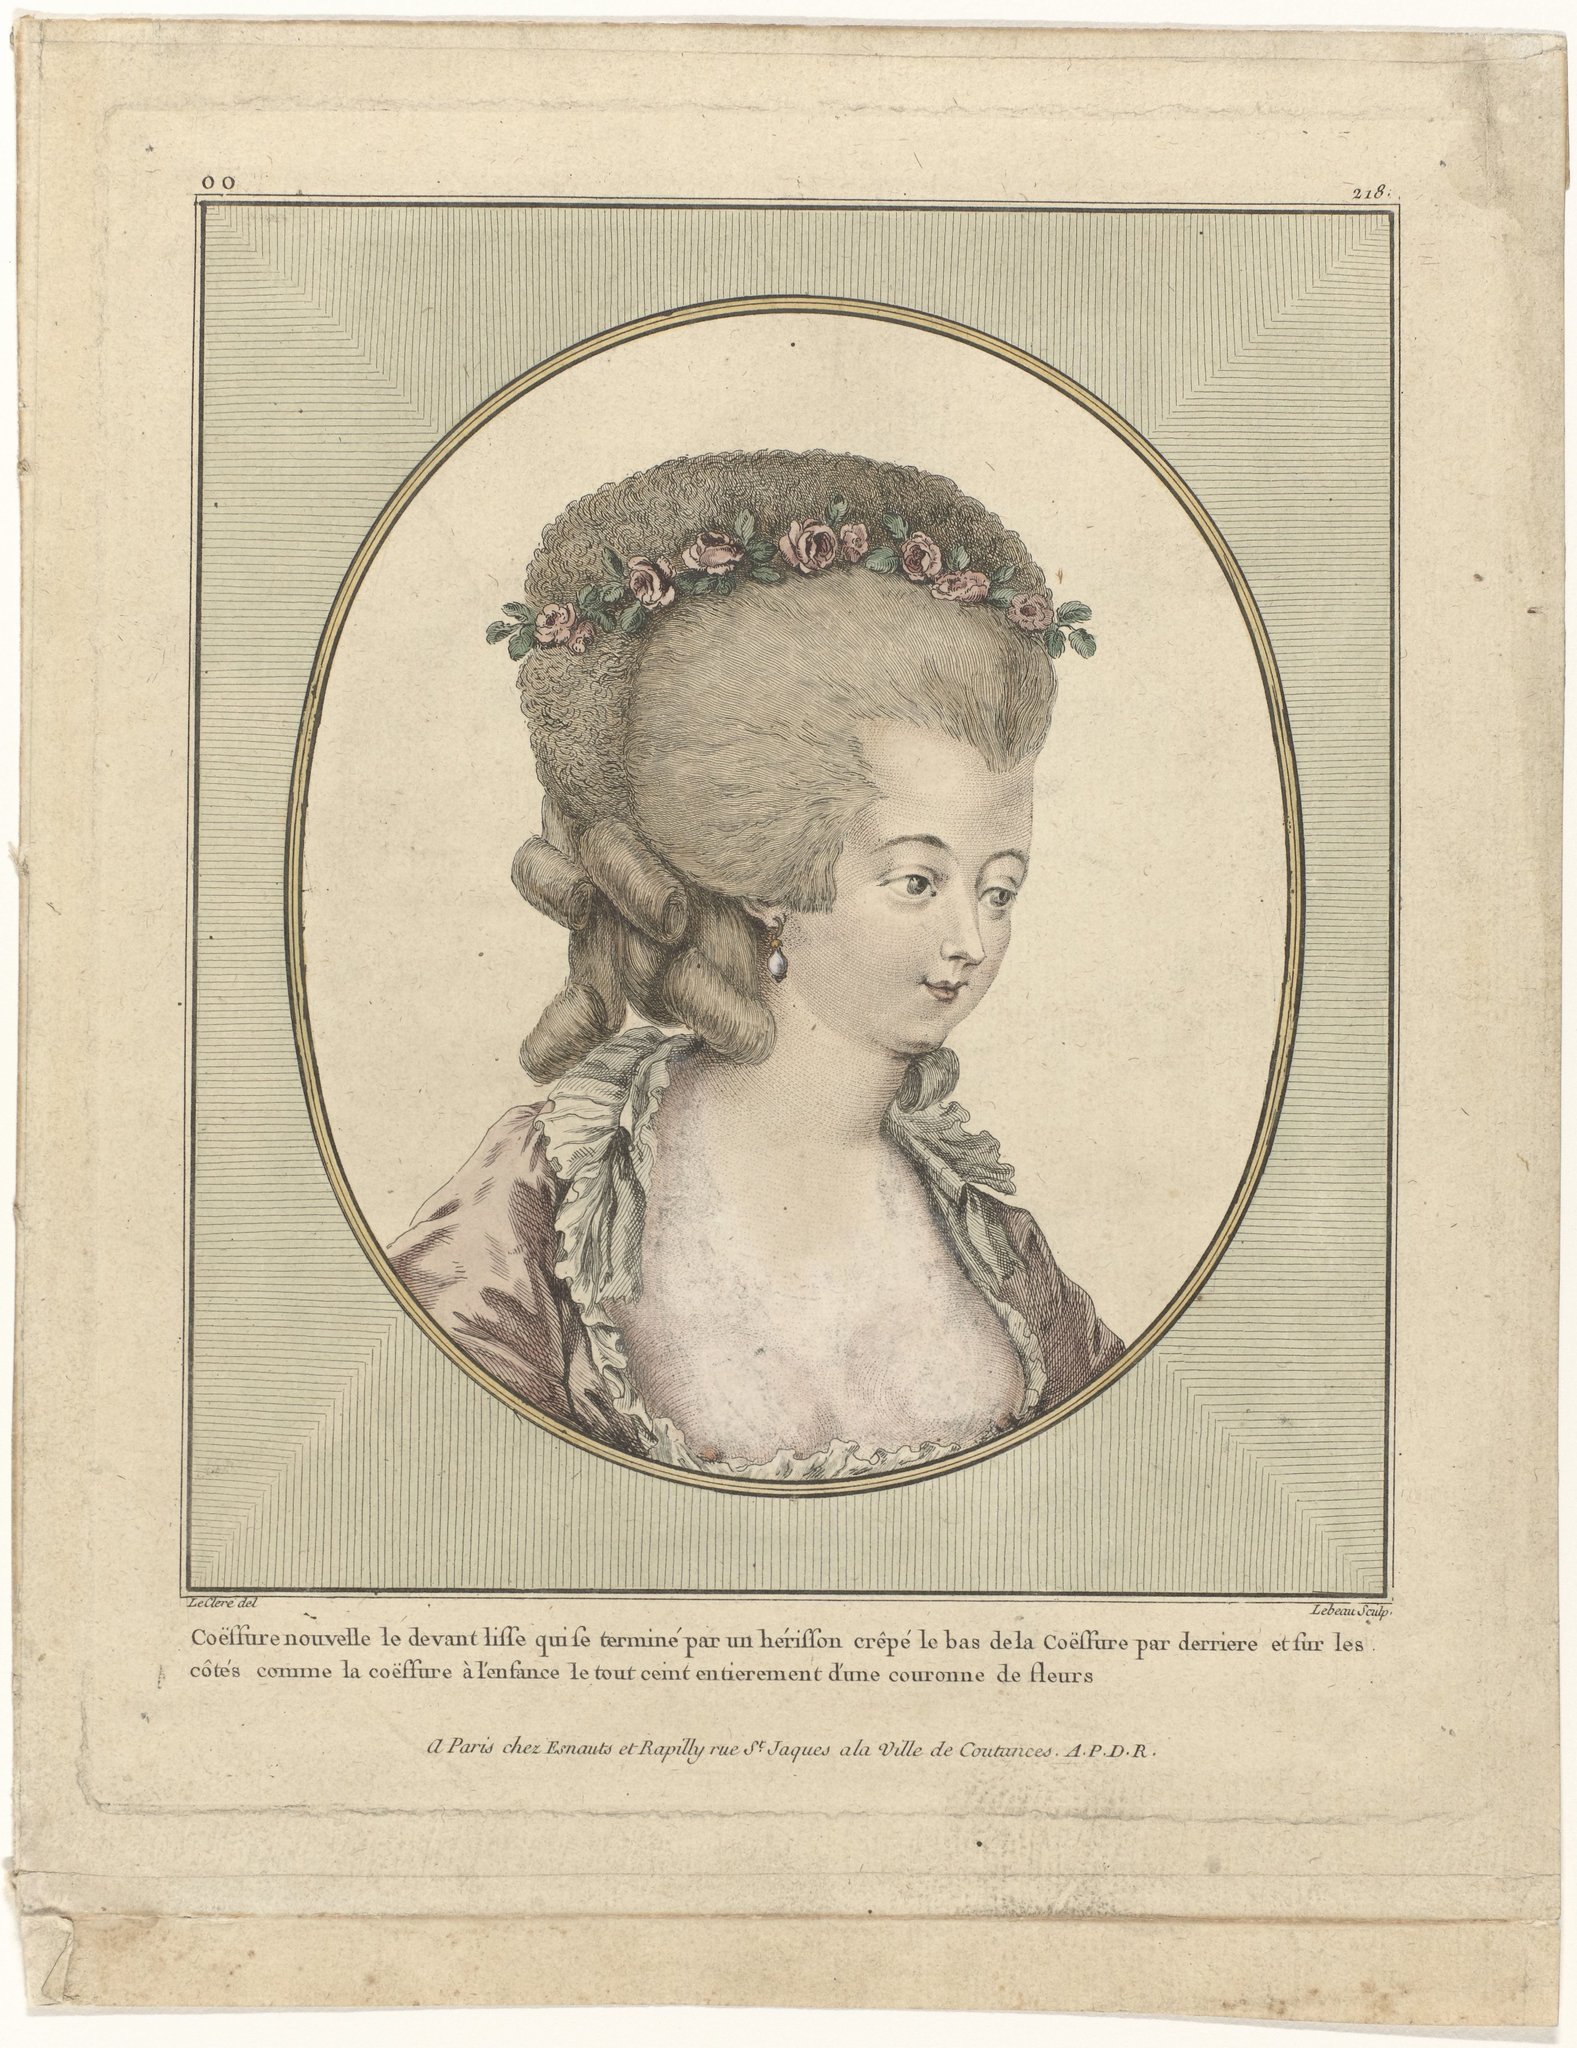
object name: fashion print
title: Gallerie des Modes et Costumes Français, 1781, oo 218 : Coeffure Nouvelle le devant (...)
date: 1781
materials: paper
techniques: engraving, hand coloring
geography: paris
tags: ear-rings (+ women's clothes), styles of hairdress (herisson) - aa - ~ women, fashion plates, breasts - aa - female human figure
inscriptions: caption: ‘Coëffure nouvelle le devant lisse qui se terminé par un hérisson crêpé le bas de la Coëffure par derriere et sur les côtés comme la coëffure à l'enfance le tout ceint entierement d'une couronne de fleurs.’, address: ‘A Paris chez Esnauts et Rapilly rue St. Jacques a la Ville de Coutances. A.P.D.R.’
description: Vrouwenbuste met diep decolleté, in ovaal. Coiffure, waarbij het haar glad naar achteren wordt gekamd, bovenop gekroesd is opgekapt als 'hérisson' en aan de achter- en zijkanten krullen heeft zoals het kapsel 'à l'enfance'. Het geheel is versierd met een kroon van bloemen. Oorbel in het rechteroor. Prent uit de serie oo. 38e Cahier des Costumes Français, 9e Suite des Coeffures à la mode en 1781, Gallerie des Modes et Costumes Français.